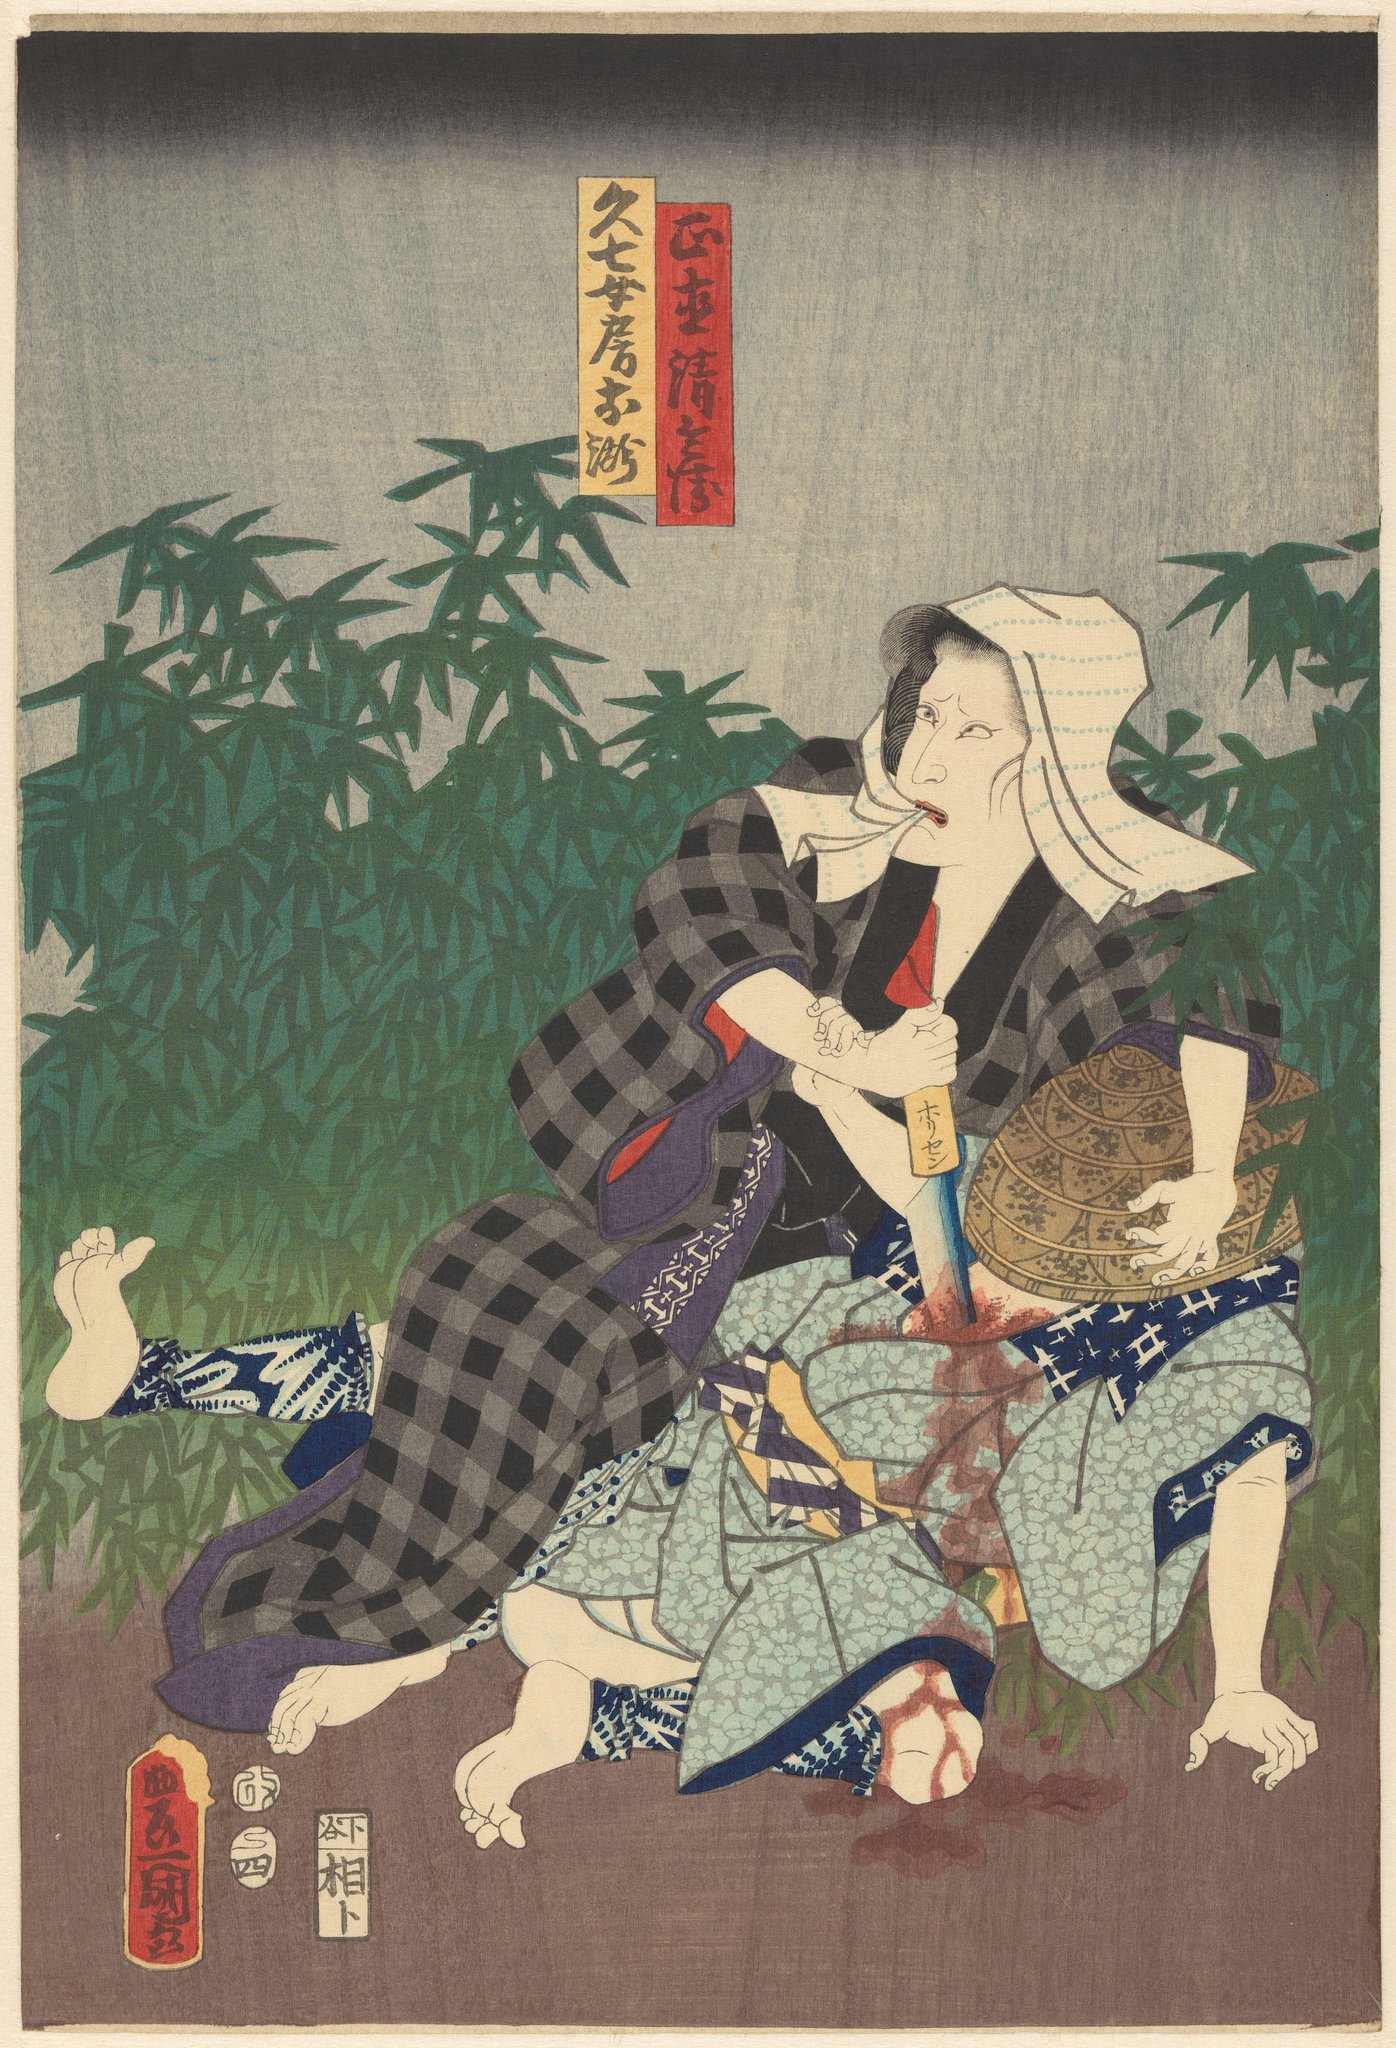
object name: print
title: Seibei vermoord door persoon met witte hoofddoek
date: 1804-1857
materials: paper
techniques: woodcut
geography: japan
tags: head-gear (with name), hacking and thrusting weapons: sword, murder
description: Seibei vermoord door persoon met witte hoofddoek. Op de achtergrond bamboe.